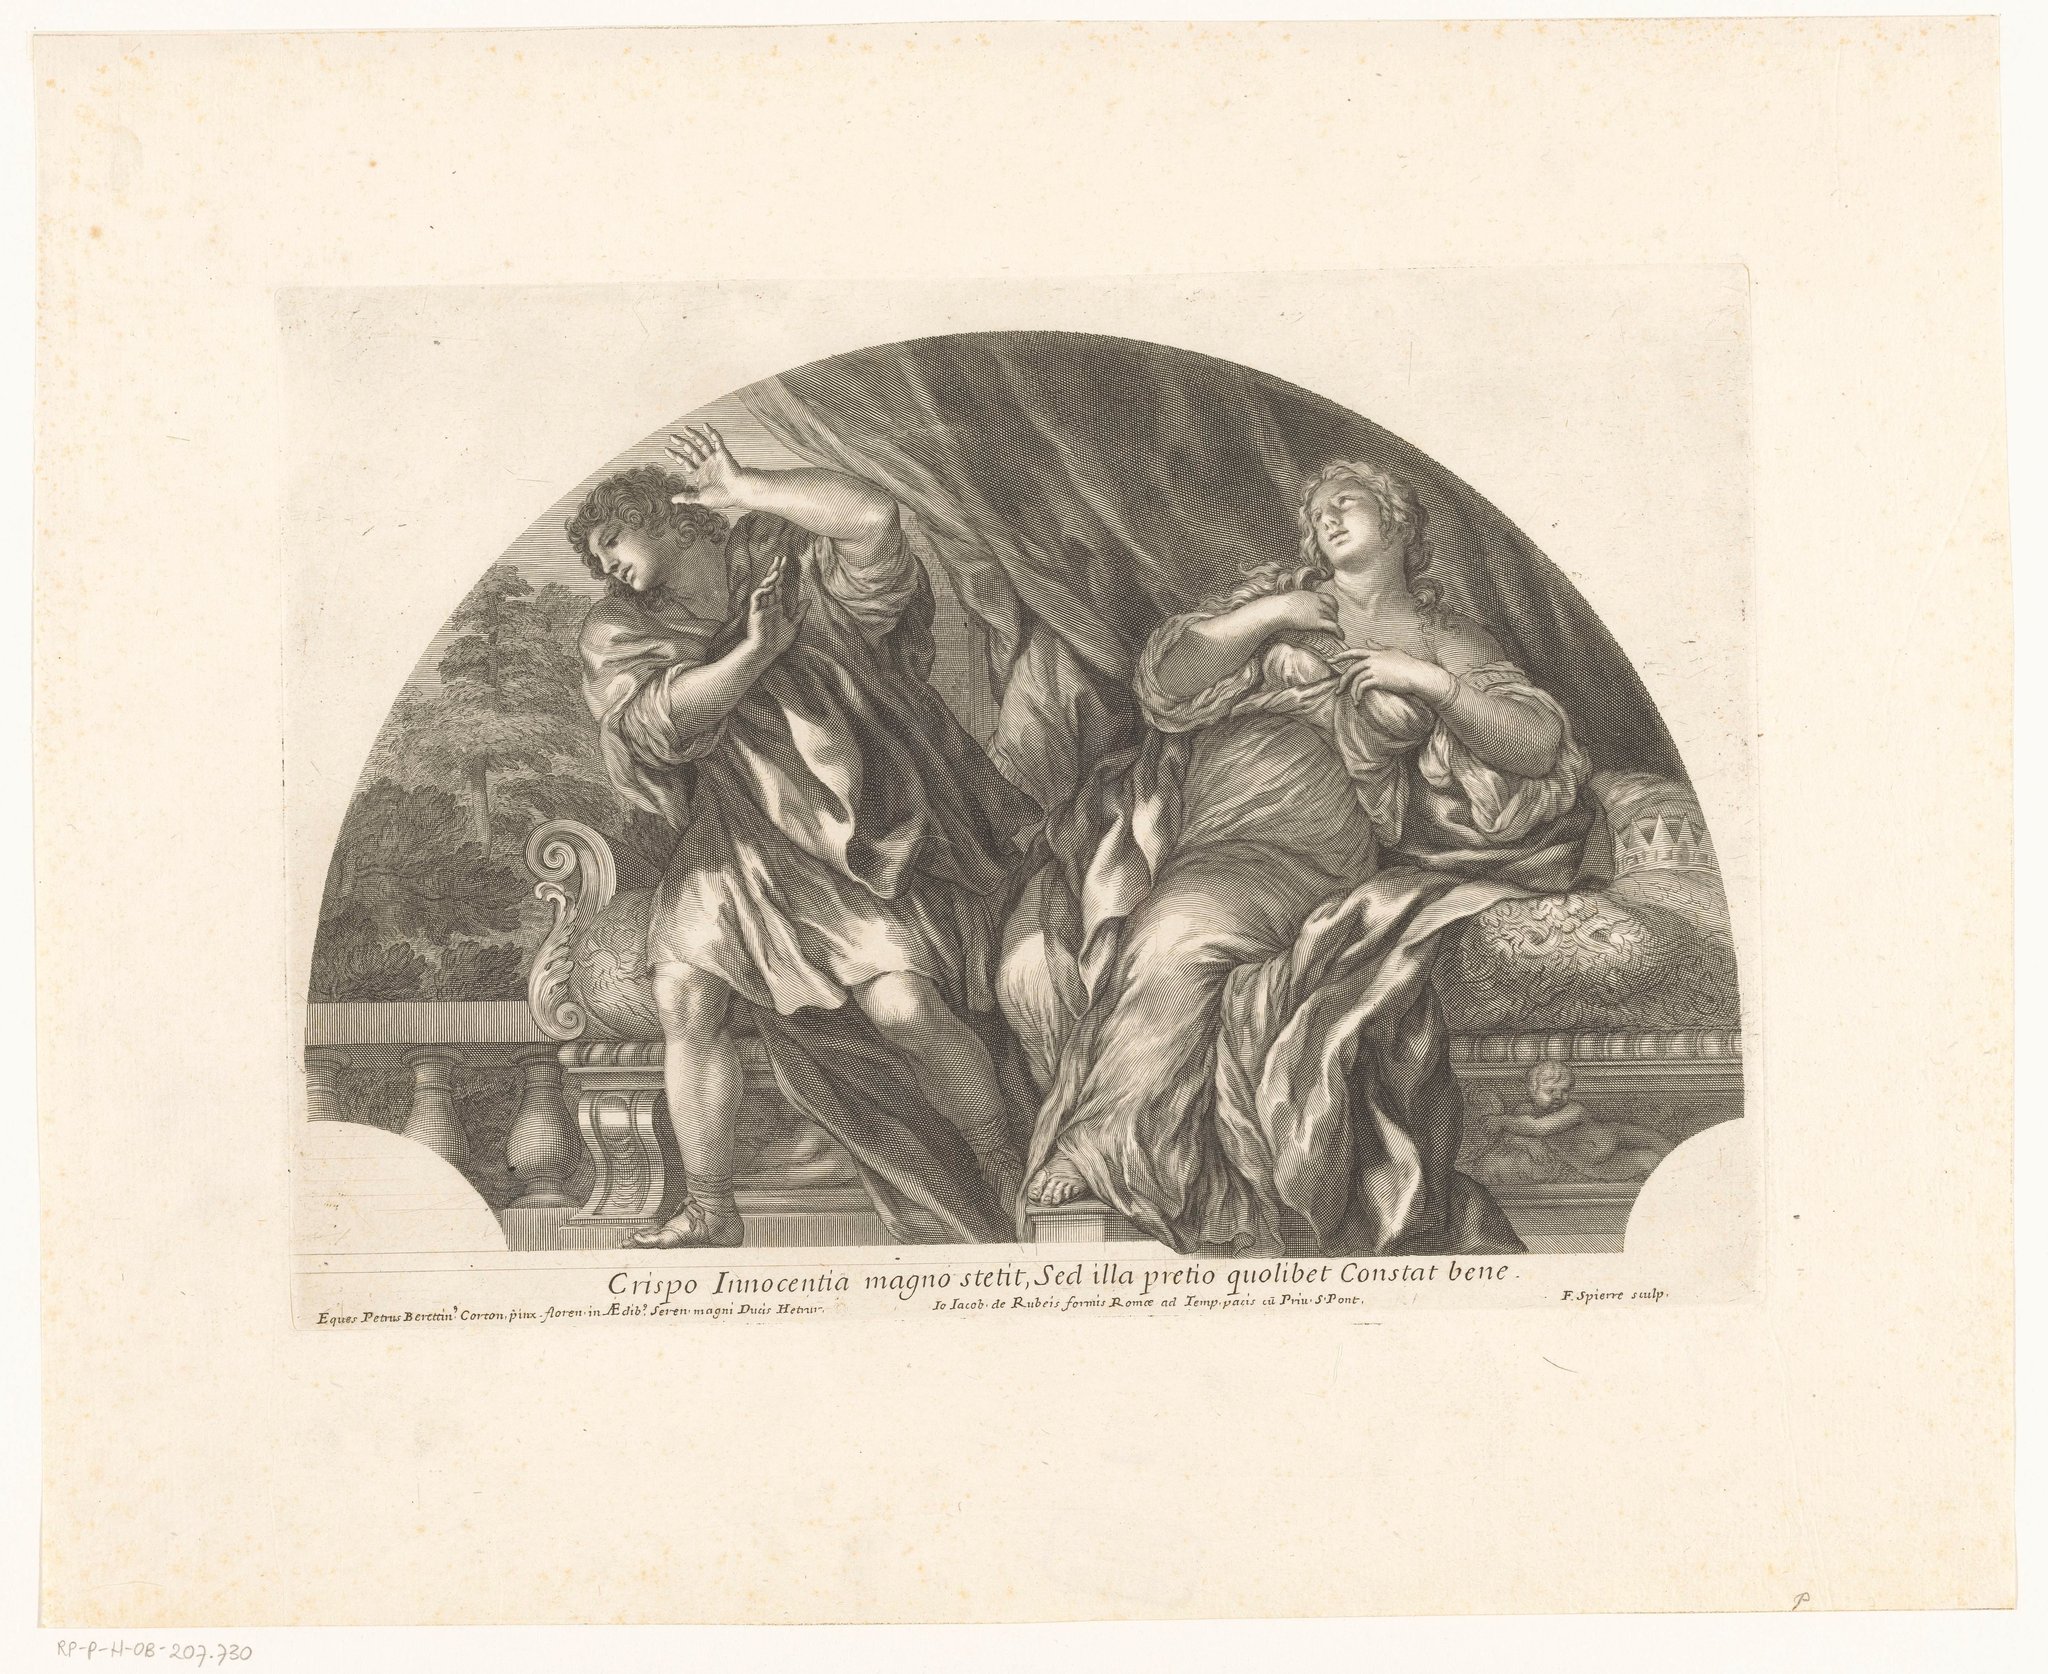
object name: print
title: Voorstellingen van heroïsche daden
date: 1677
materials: paper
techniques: engraving, etching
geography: rome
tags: ulysses, tied to the mast of his ship, passes the sirens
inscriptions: collector's mark: ‘Hinloopen’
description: Naar een fresco door Pietro da Cortona in de Sala di Venere in Palazzo Pitti te Florence. De prent maakt deel uit van een reeks van 15 ongenummerde prenten. Deze prent maakte oorspronkelijk deel uit van liber nr. 22 van de Atlas van Rome, uit de collectie Hinloopen. In dit album waren een aantal prentreeksen naar bekende zeventiende eeuwse frescoseries bijeengebonden. In 1709 heeft Schijnvoet op last van de burgemeesters van Amsterdam de collectie herordend. De prenten uit liber 22 kwamen terrecht in Schijnvoet boek nr. 10. De laatst gedateerde reeks in het album is gedateerd 1691. Het album moet dus na deze datum gebonden zijn. De band is in de Rijksakademietijd uit elkaar gehaald. De marges van de prenten zijn bij het opbergen in het Rijksprentenkabinet vaak drastisch afgesneden. Van een aantal series waren de prenten teruggeslagen om in het album te passen. (Zie: Waals, Jan van der. De prentschat van Michiel Hinloopen. 's-Gravenhage: SDU uitgeverij, 1988, pp. 173-174.)